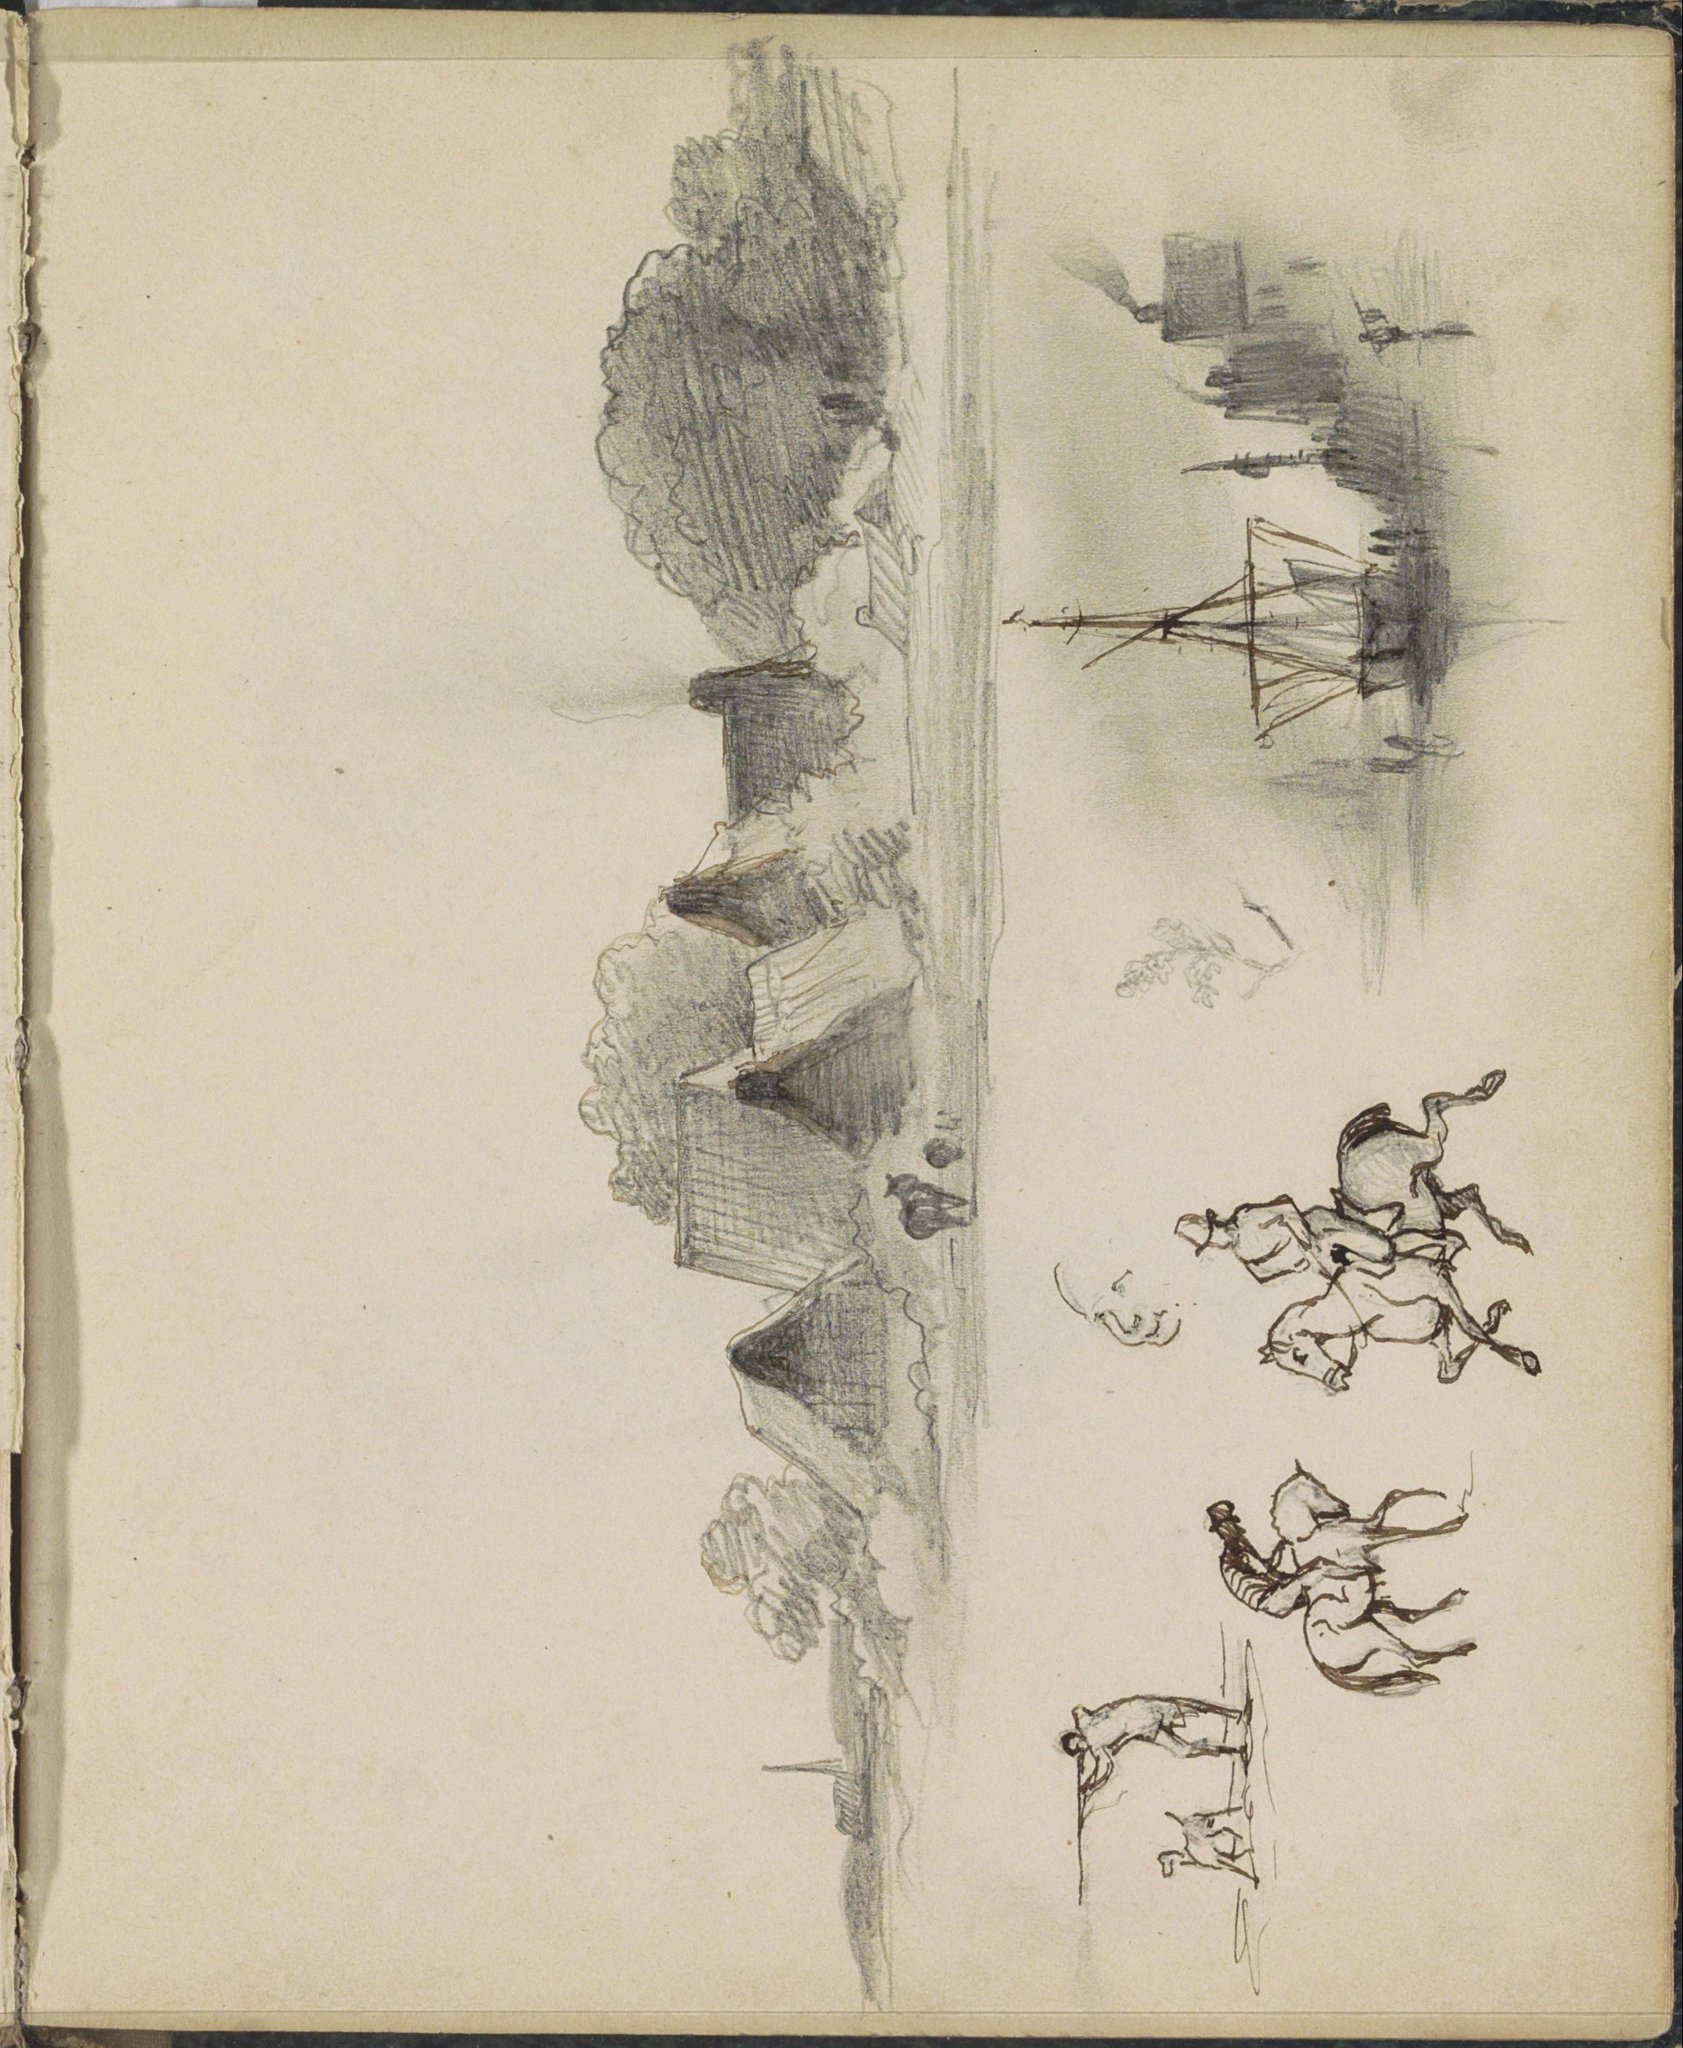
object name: sketchbook leaf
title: Studieblad, onder andere met ruiters, een jager en aangemeerde zeilschepen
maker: johannes tavenraat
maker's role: draughtsman, painter, print maker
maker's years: 1809-1881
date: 1841-1853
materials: ink, paper, pencil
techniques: pen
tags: riding a horse, ass, or mule; rider, horseman, sailing-ship, sailing-boat, hunter, meadow, pasture, rural housing, e.g. country-house, villa, cottage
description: Tevens een studie van huizen tussen de bomen in een weidelandschap. Blad 48 recto uit een schetsboek met 87 bladen.